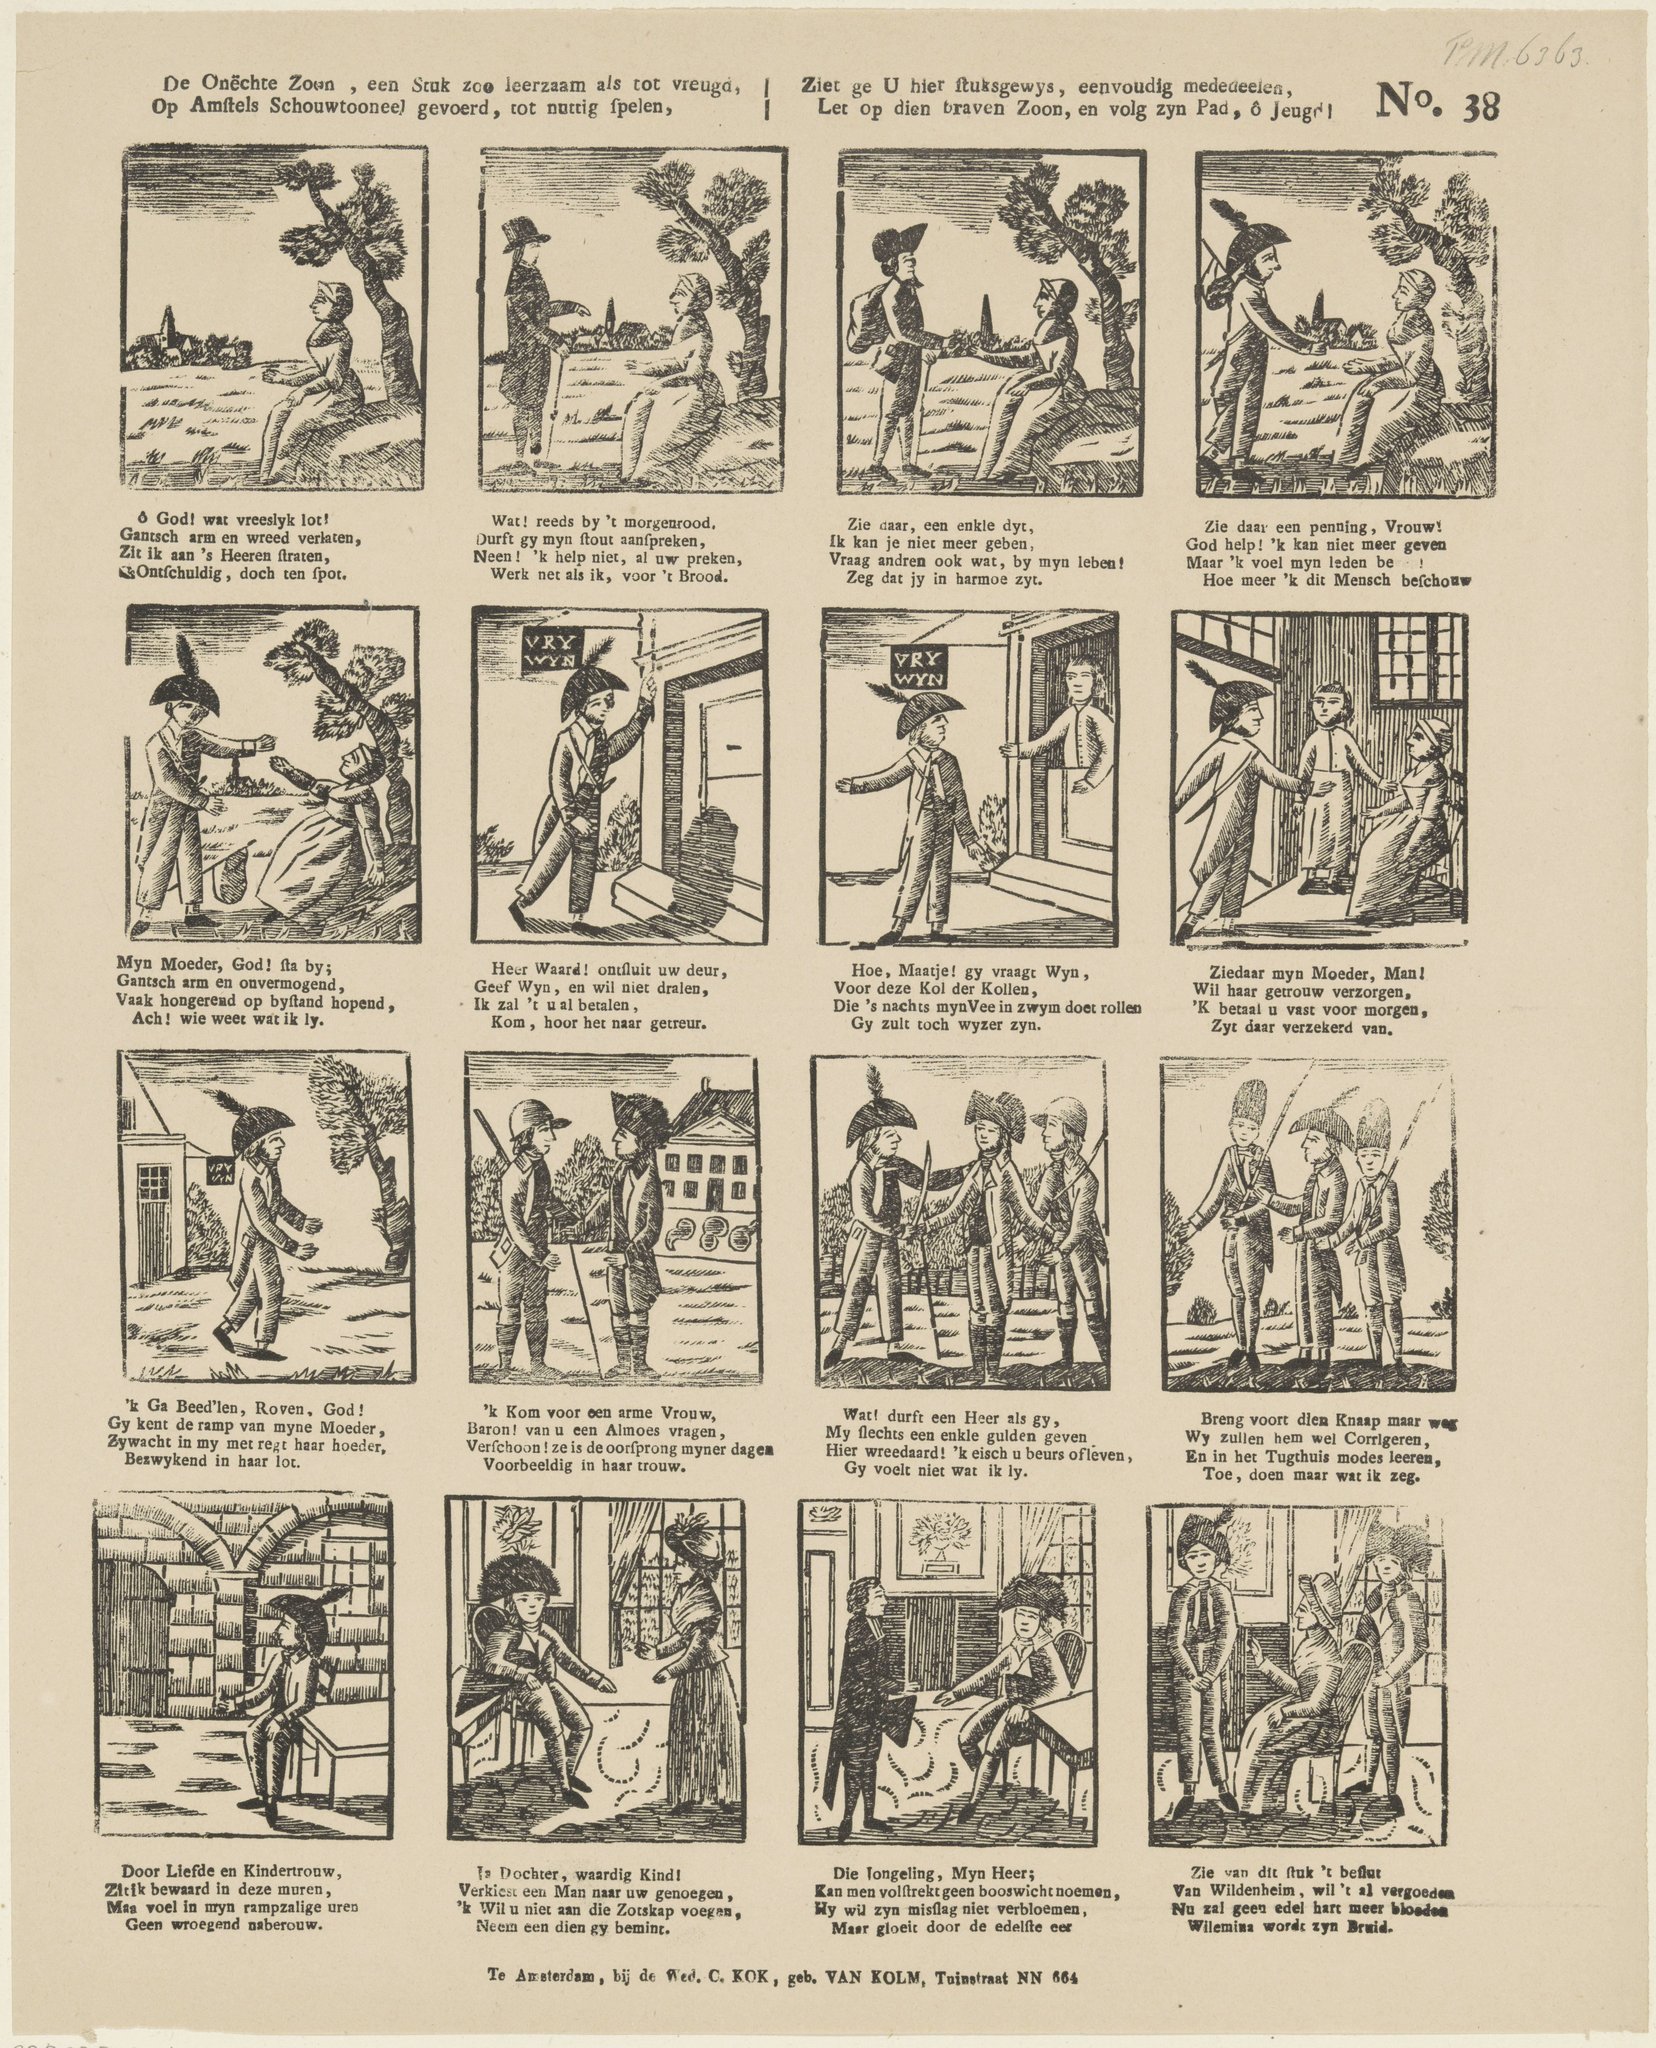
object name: print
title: De onëchte zoon, een stuk zoo leerzaam als tot vreugd, / Op Amstels schouwtoneel gevoerd, tot nuttig spelen, / Ziet ge u hier stuksgewys, eenvoudig mededeelen, / Let op dien braven zoon, en volg zyn pad, ô jeugd!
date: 1842-1866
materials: paper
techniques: letterpress printing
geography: amsterdam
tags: good behaviour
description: Blad met 16 voorstellingen van een jongeman die goede daden doet. Onder elke afbeelding een vierregelig vers. Genummerd rechtsboven: No. 38.